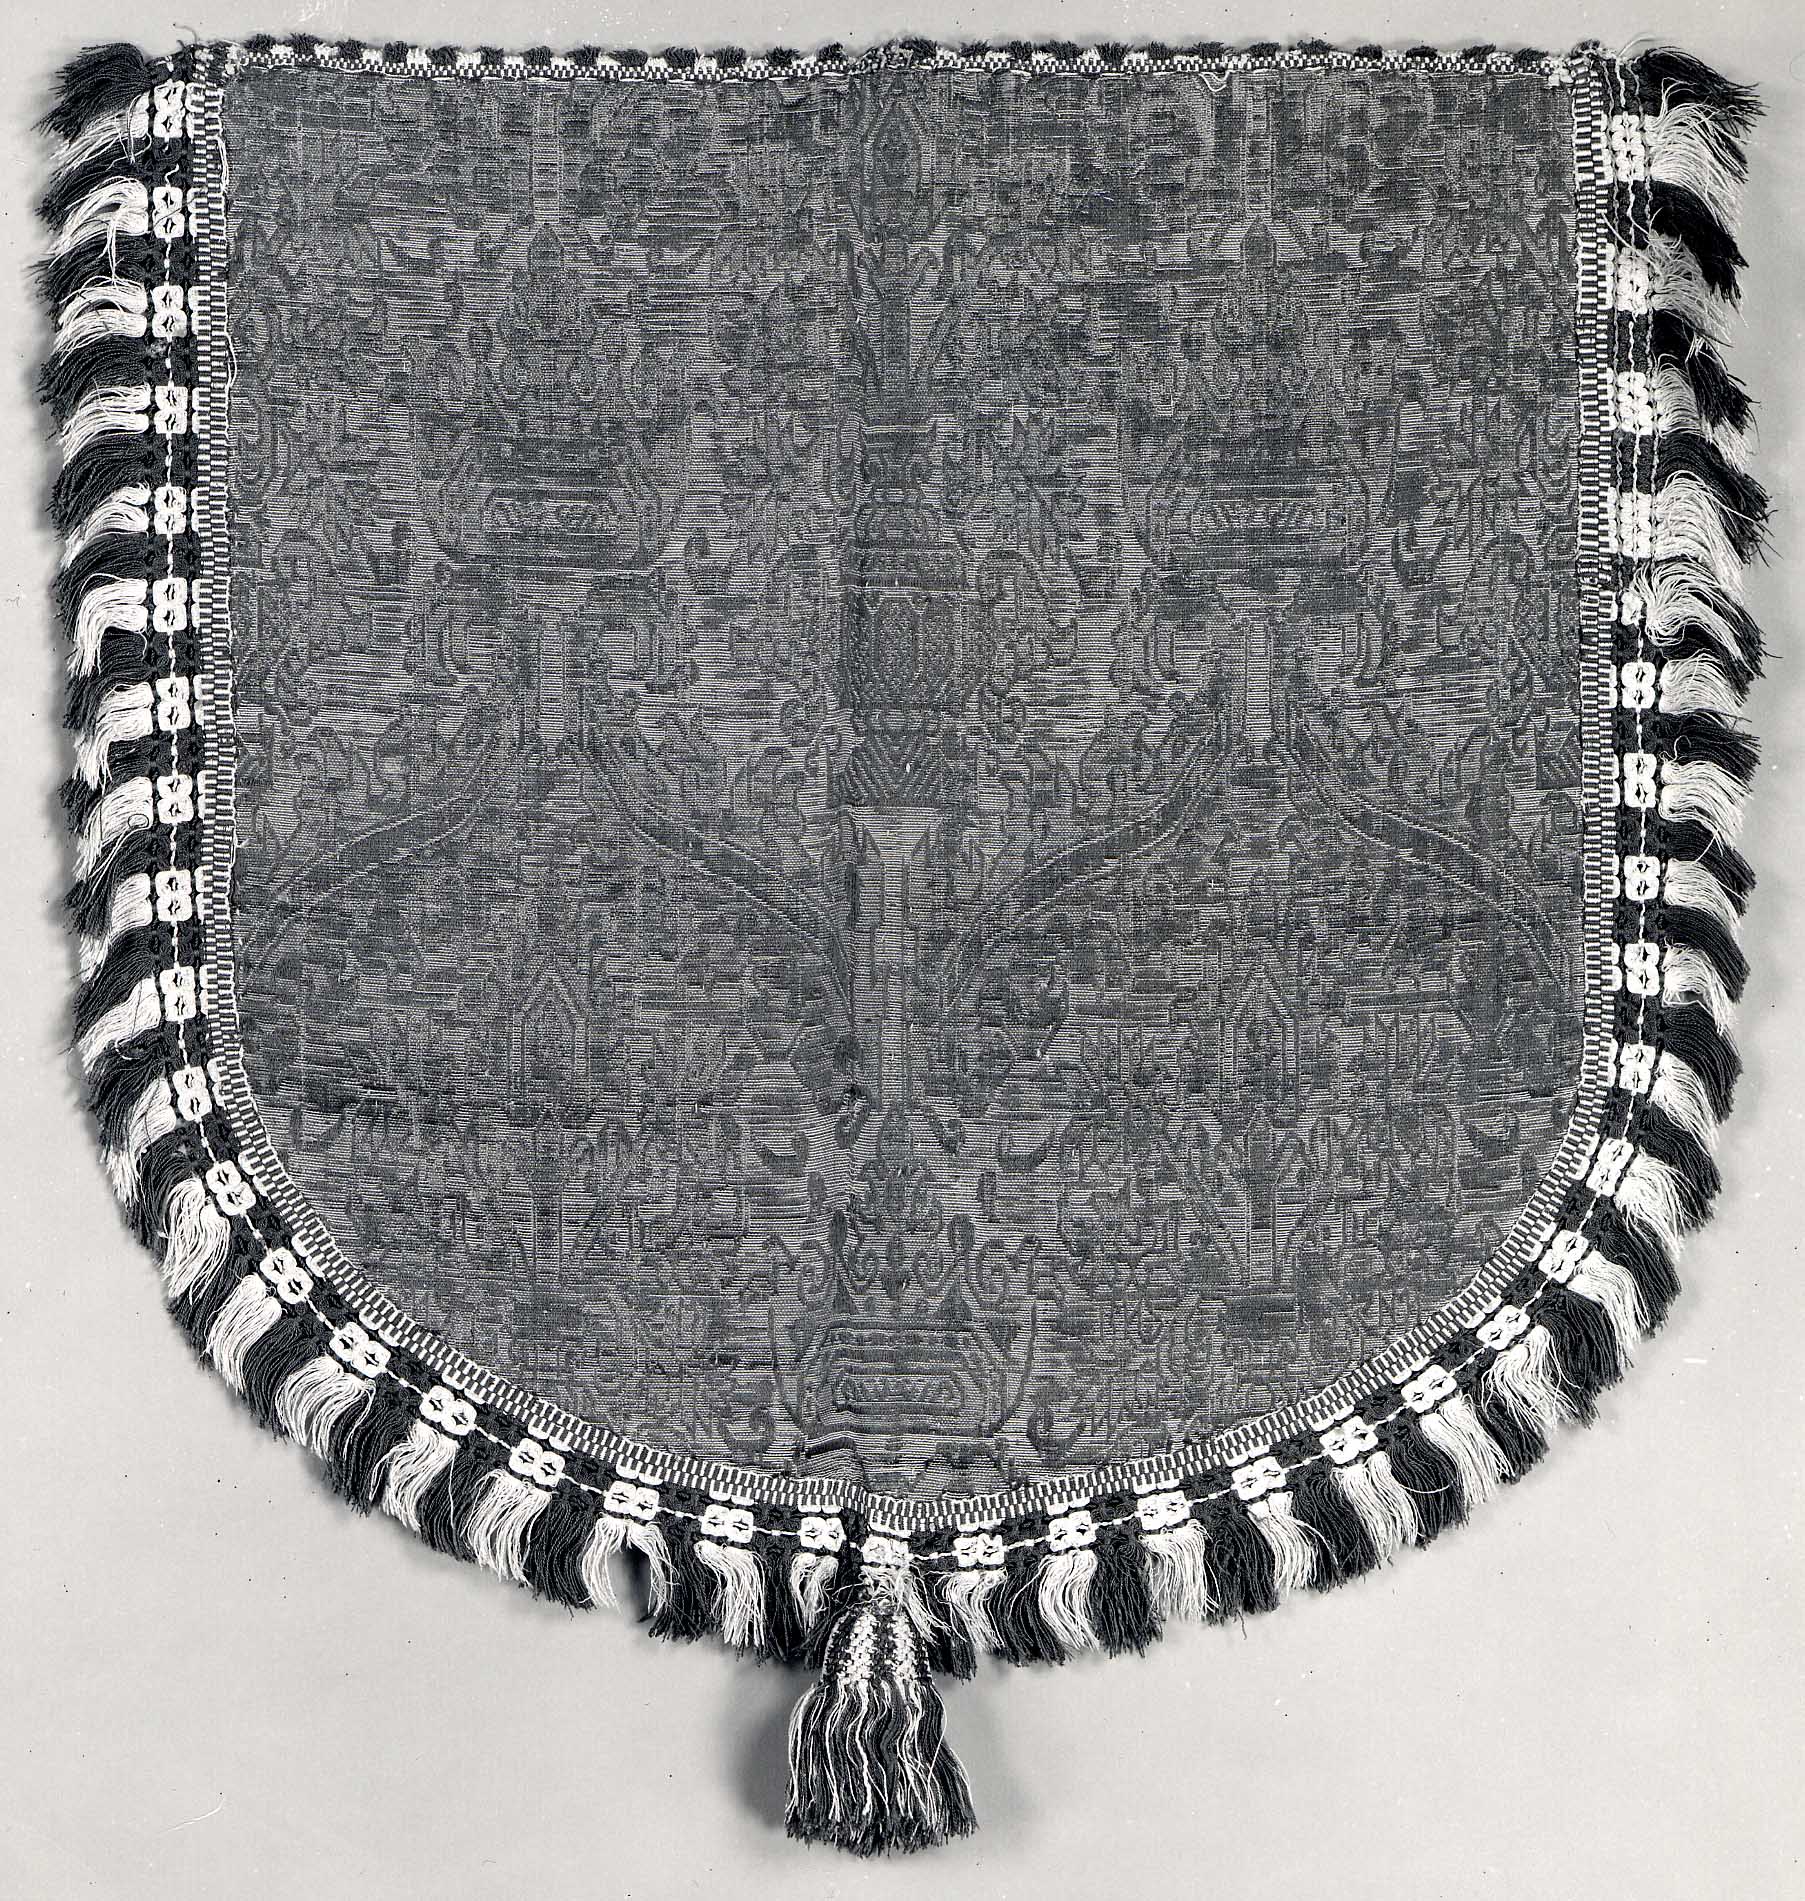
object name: hood from a cope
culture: spanish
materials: linen, silk